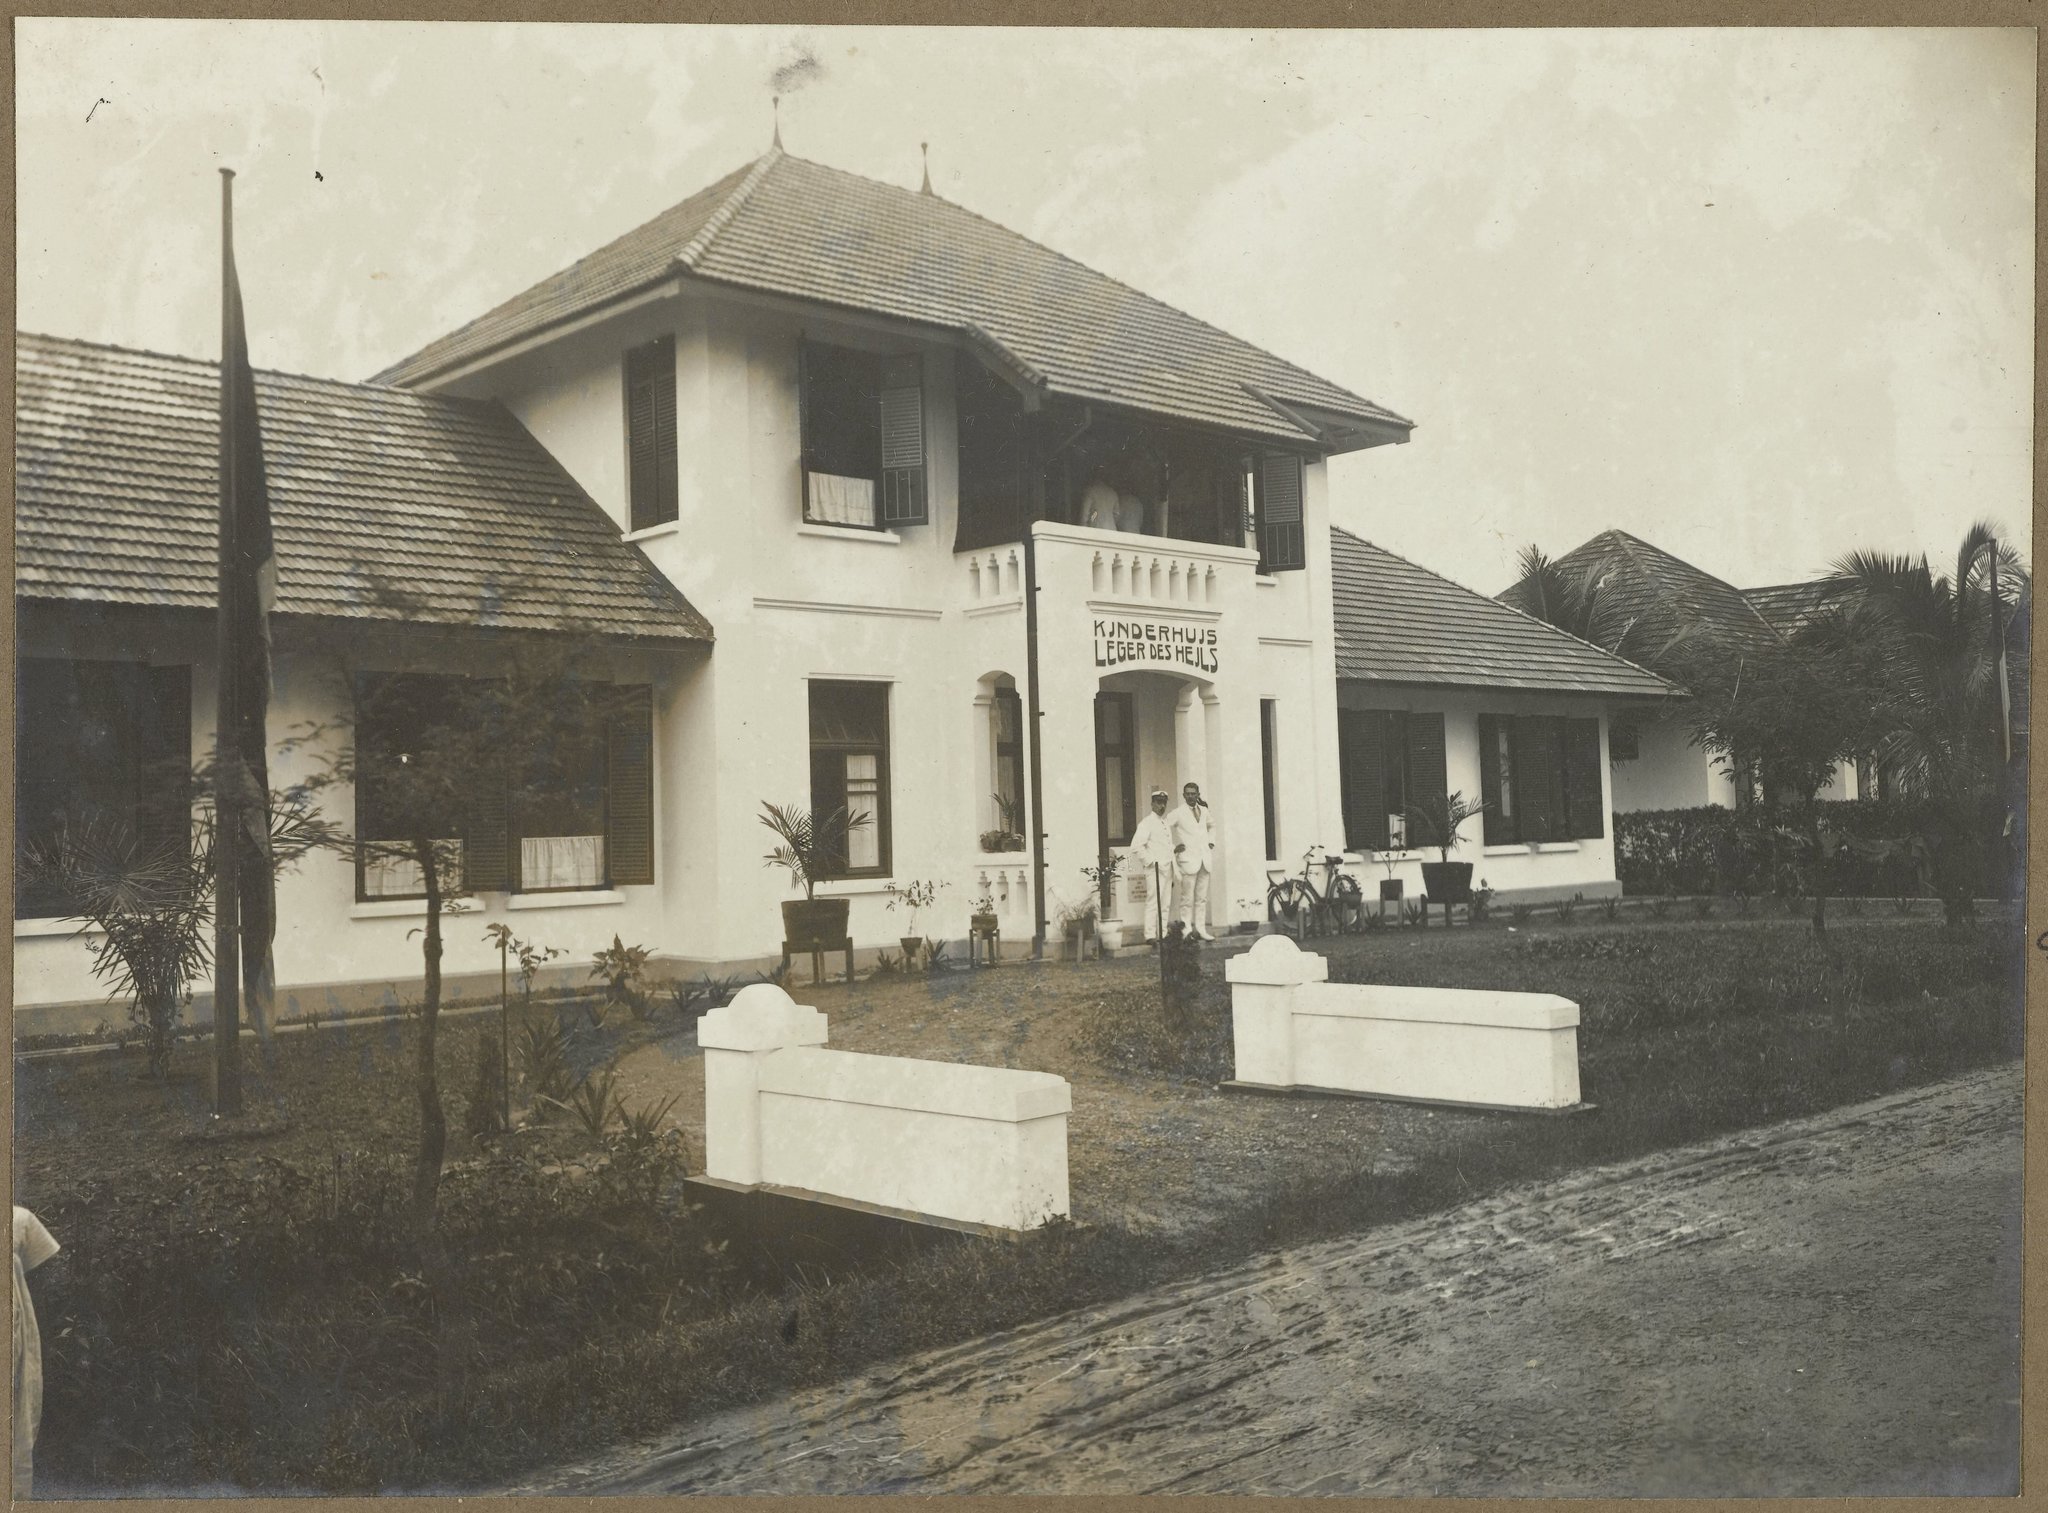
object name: photograph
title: Kinderhuis van het Leger des Heils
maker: Anonymous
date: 1916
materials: photographic support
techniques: gelatin silver print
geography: medan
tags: representation of real building (either existing or having existed), architecture, orphanage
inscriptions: inscription: ‘Medan Wilhelmina Straat 32 - Gebouwd 1916 / Rechts Ernaast Geboorte Huis W.G. Riphagen’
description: Het in 1916 gebouwde Kinderhuis van het Leger des Heils aan de Wilhelminastraat 32 te Medan. Rechts op nr. 30 het geboortehuis van Willy Riphagen, de zoon van de architect. Foto in het fotoalbum van het Nederlandse architectenbureau en aannemersbedrijf Bennink en Riphagen te Medan in de jaren ca. 1914-1919.